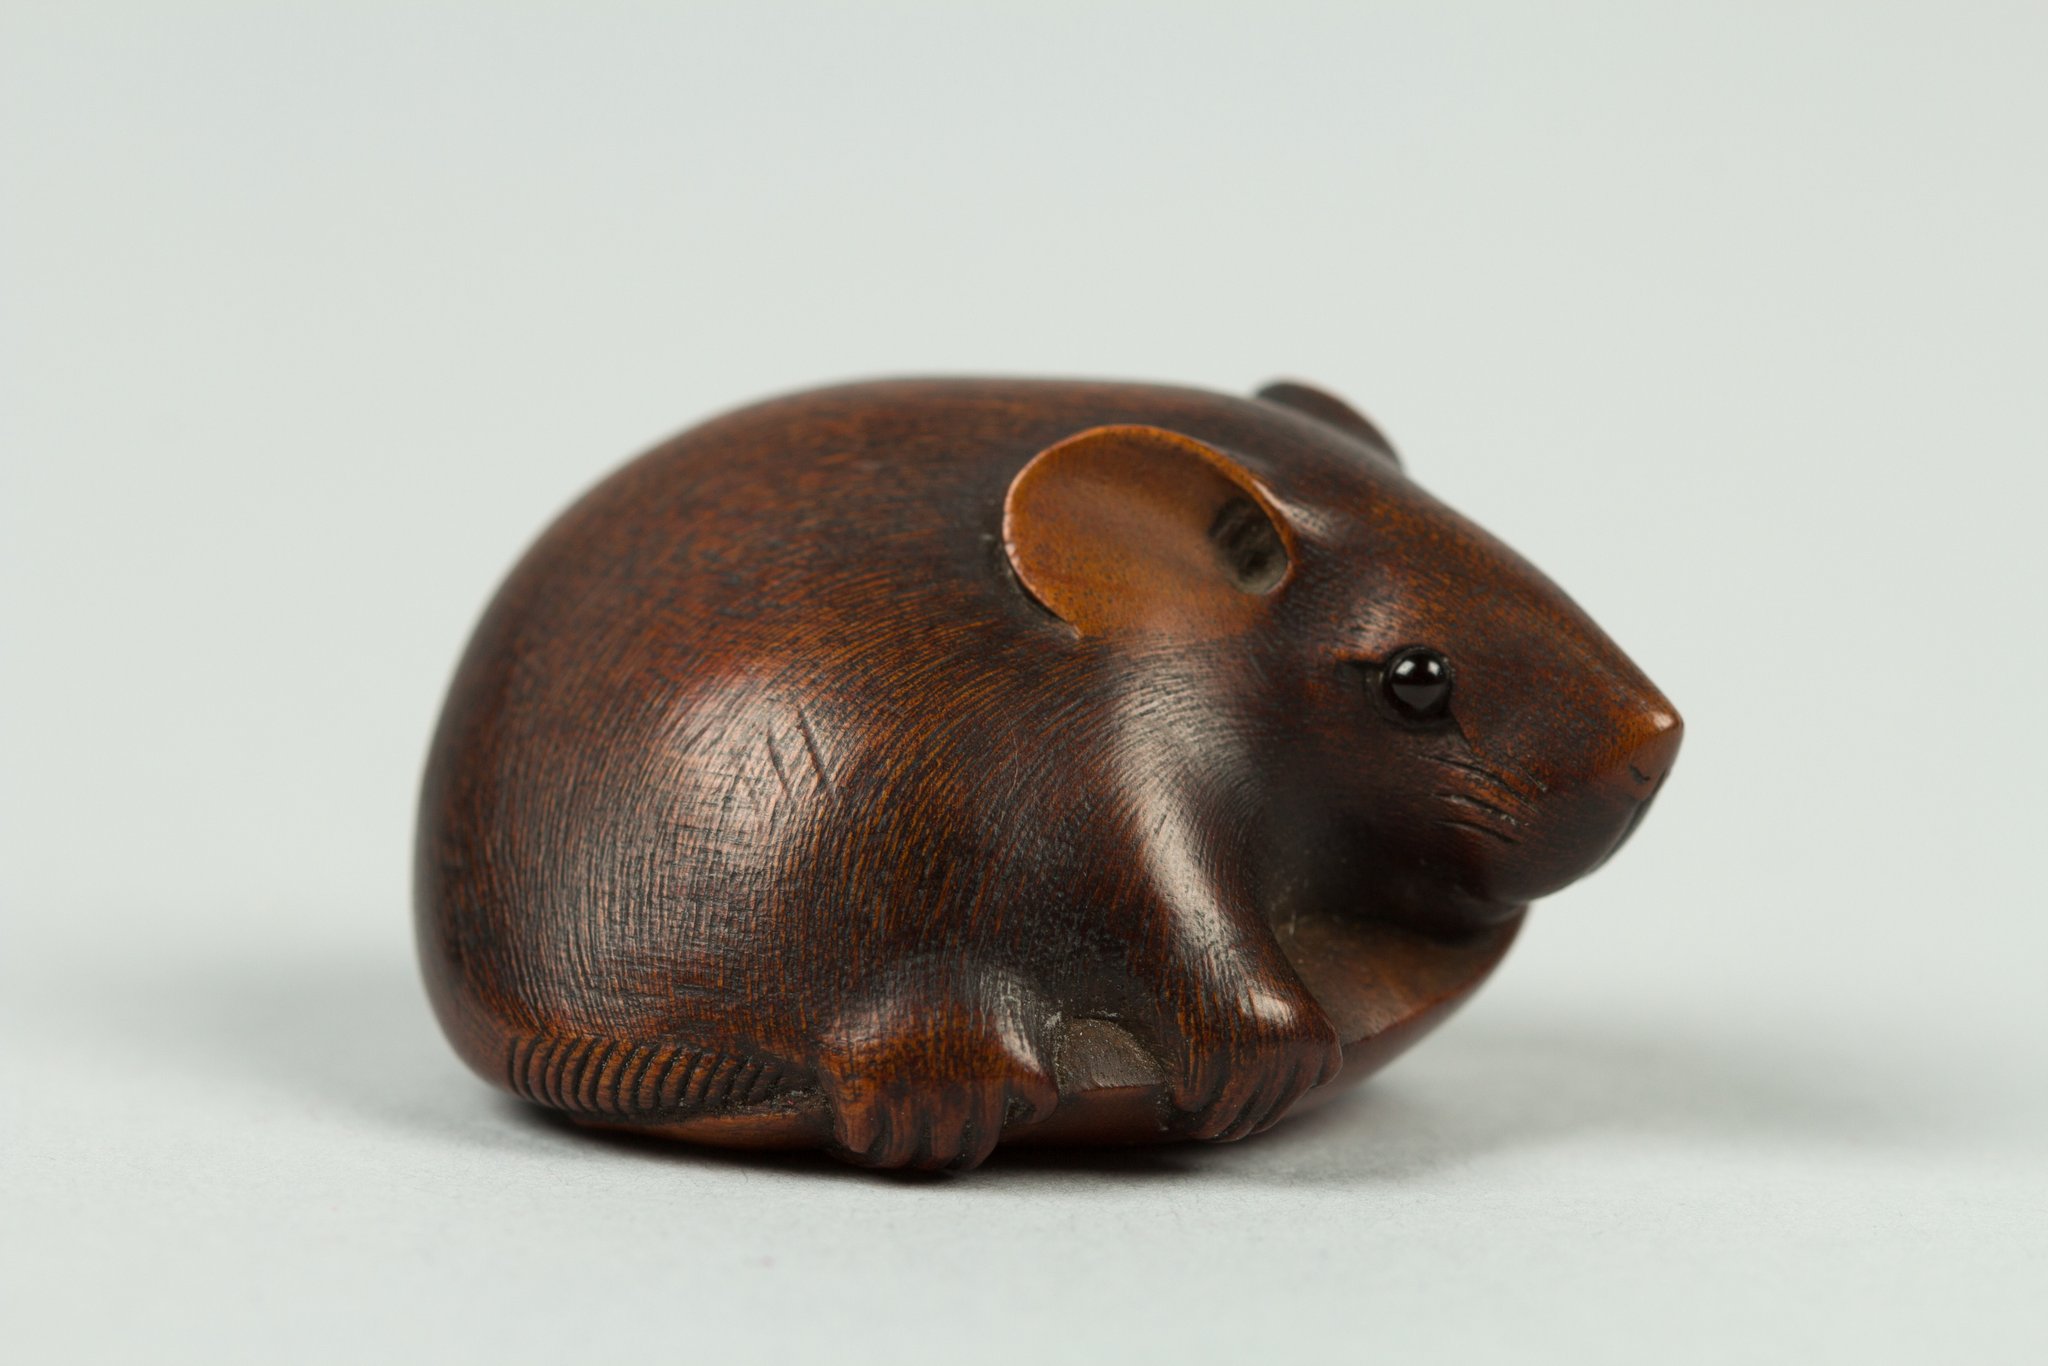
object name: netsuke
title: Netsuke of a Rat Grasping a Soybean Pod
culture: japanese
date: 1801-1833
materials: wood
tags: animals,rats